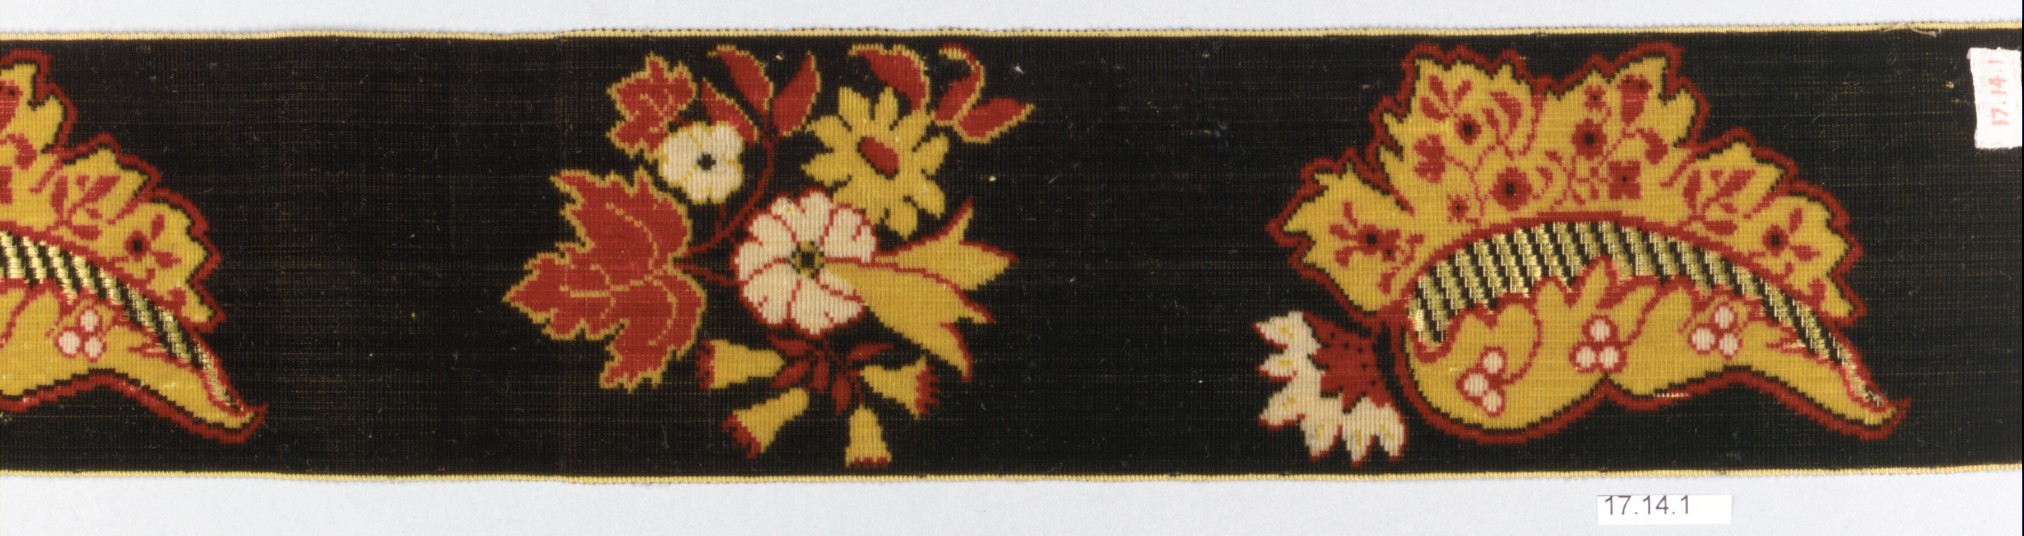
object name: ribbon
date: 1701-1800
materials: velvet